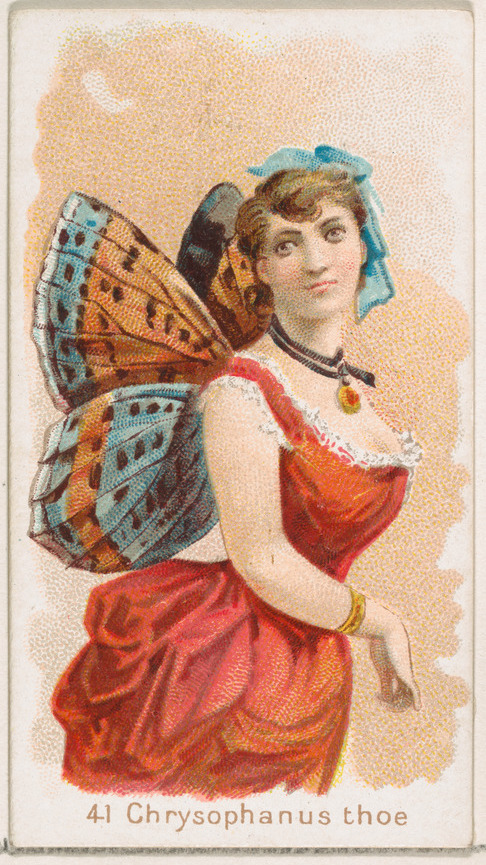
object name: print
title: Card 41, Chrysophanus Thoe, from the Butterflies series (N183) issued by Wm. S. Kimball & Co.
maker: william s. kimball & company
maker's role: publisher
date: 1888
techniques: color lithograph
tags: women,butterflies